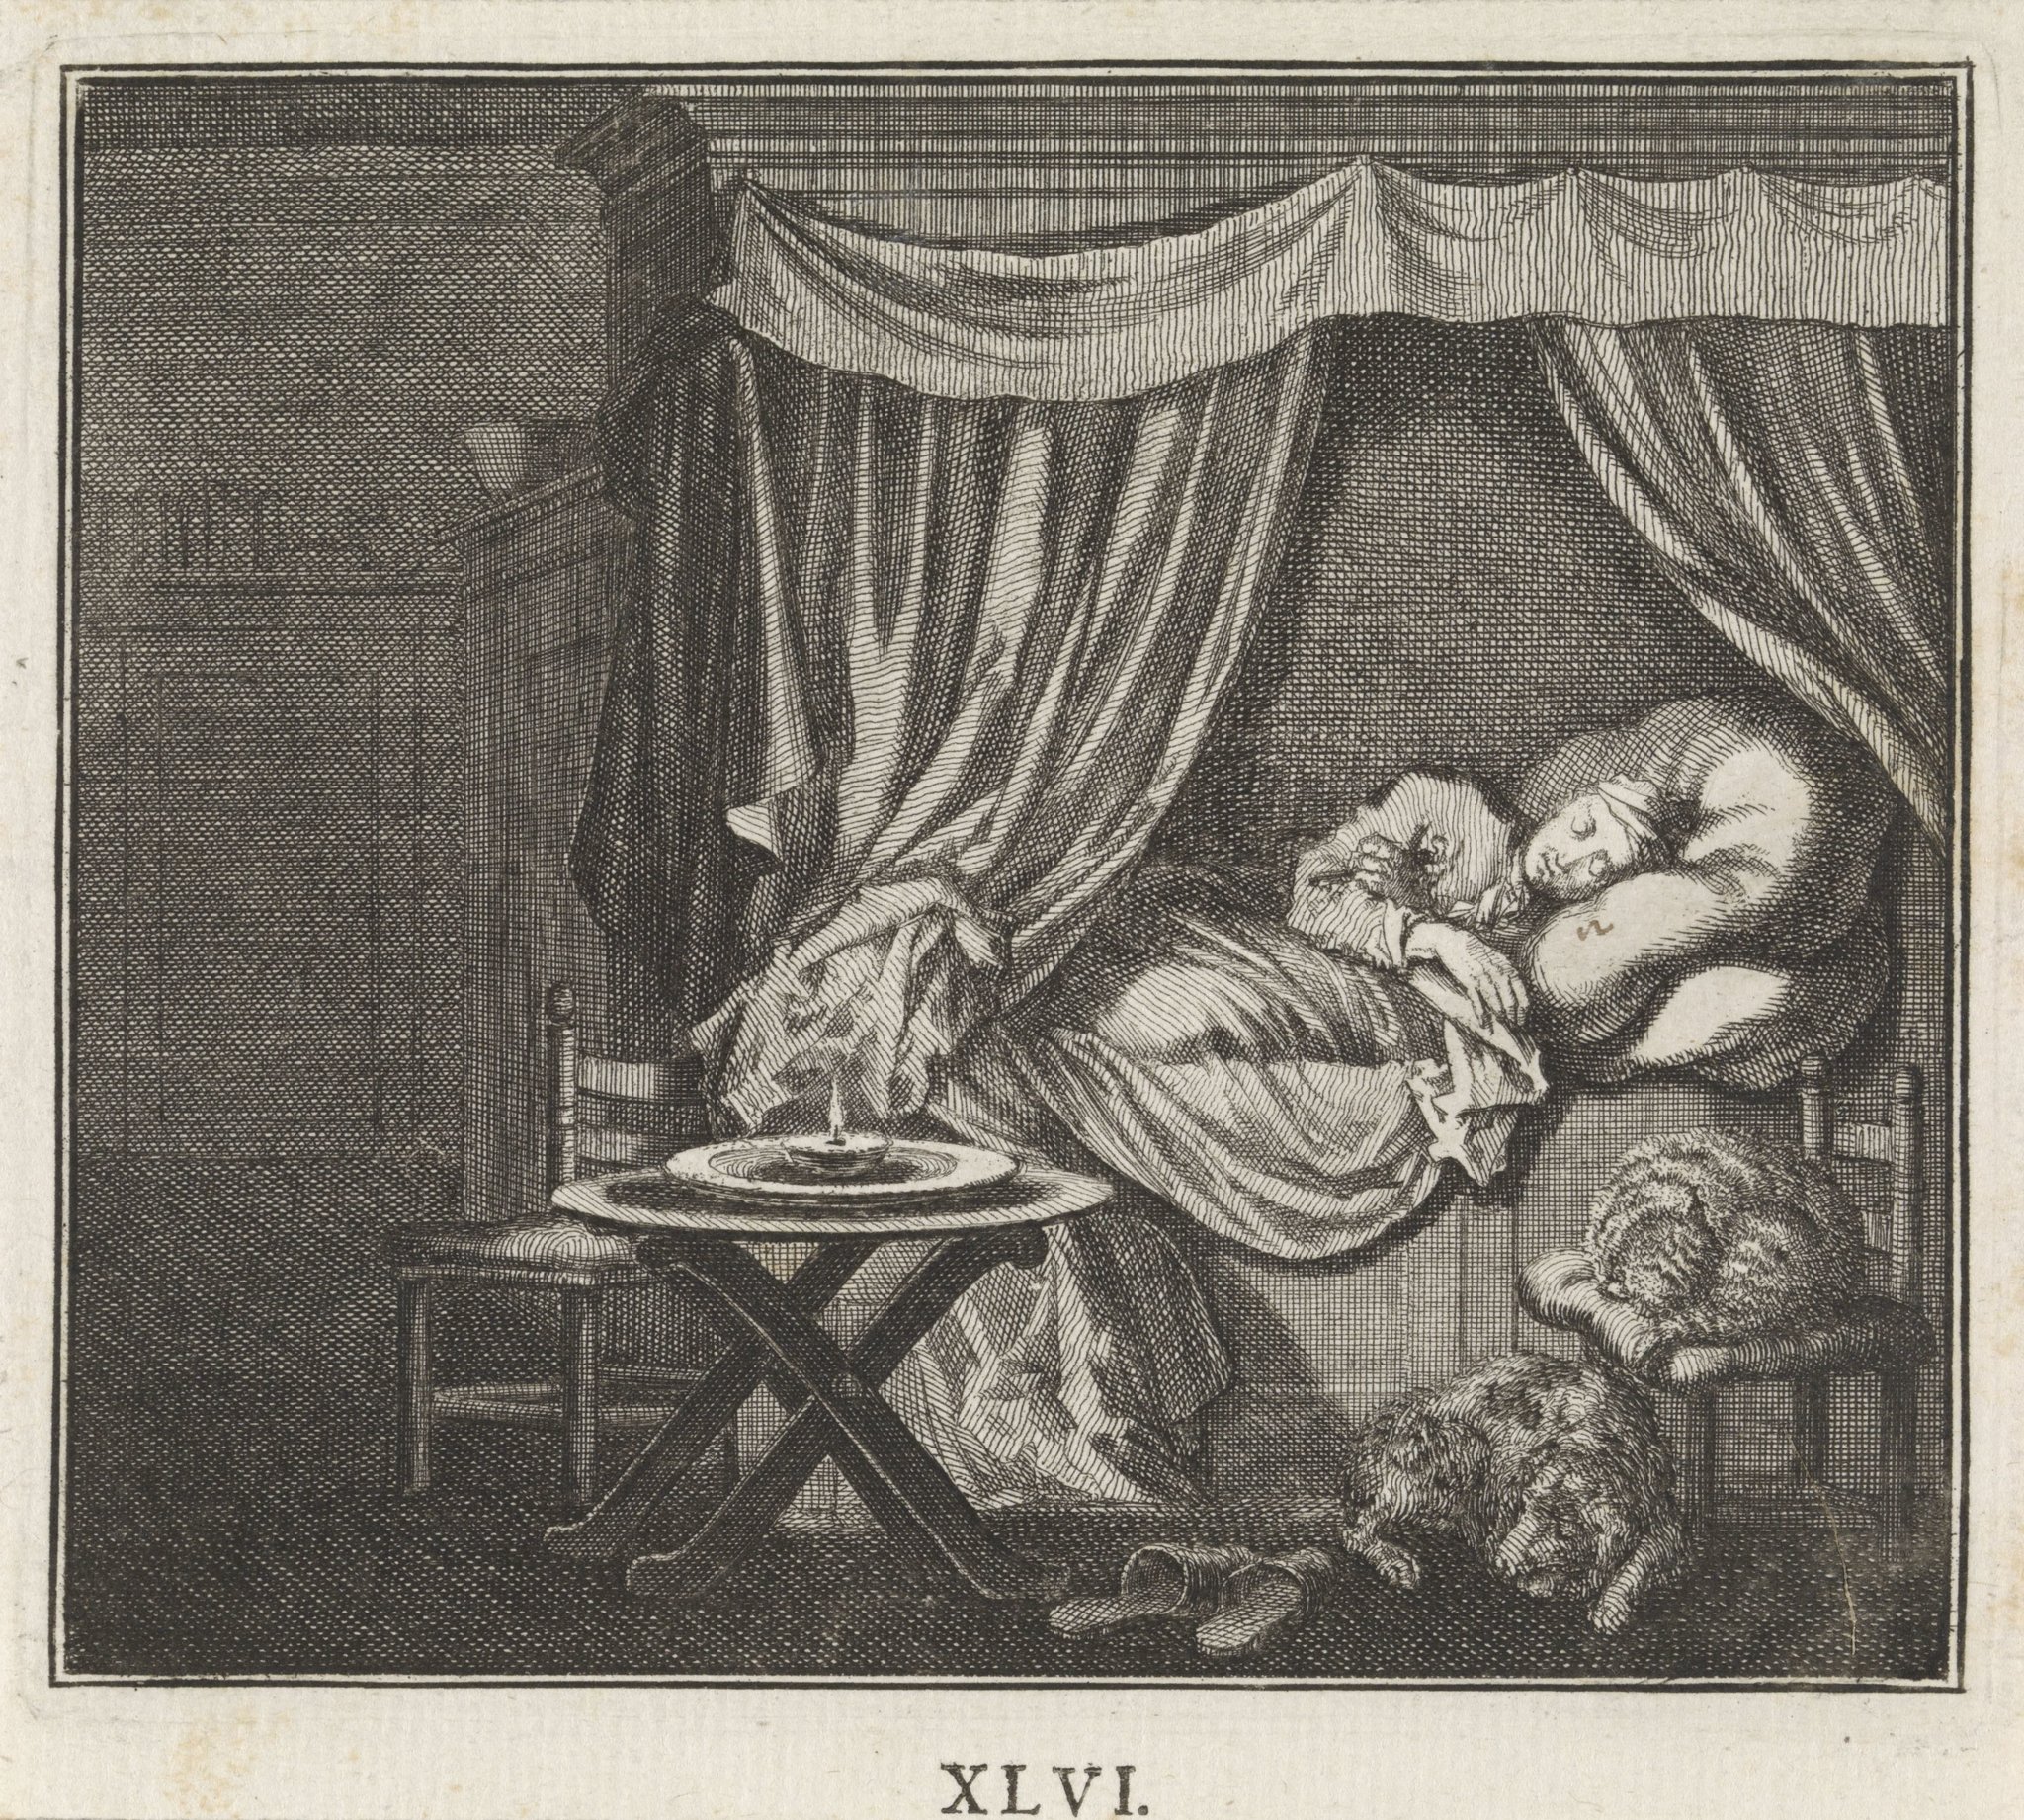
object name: print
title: Embleem: nacht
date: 1695-1705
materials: paper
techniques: etching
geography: amsterdam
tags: cat (+ sleeping animal(s)), bathroom, sleeping in bed, bed, dog (+ sleeping animal(s)), night, abstract ideas and concepts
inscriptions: collector's mark: Lugt 2228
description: Boekillustratie voor Weigel, Christoph. Ethica Naturalis seu Documenta Moralia e Variis rerum Naturalium proprietatibus Virtutum Vitiorumq symbolicis imaginibus collecta. Neurenberg: Christoph Weigel: c. 1700.